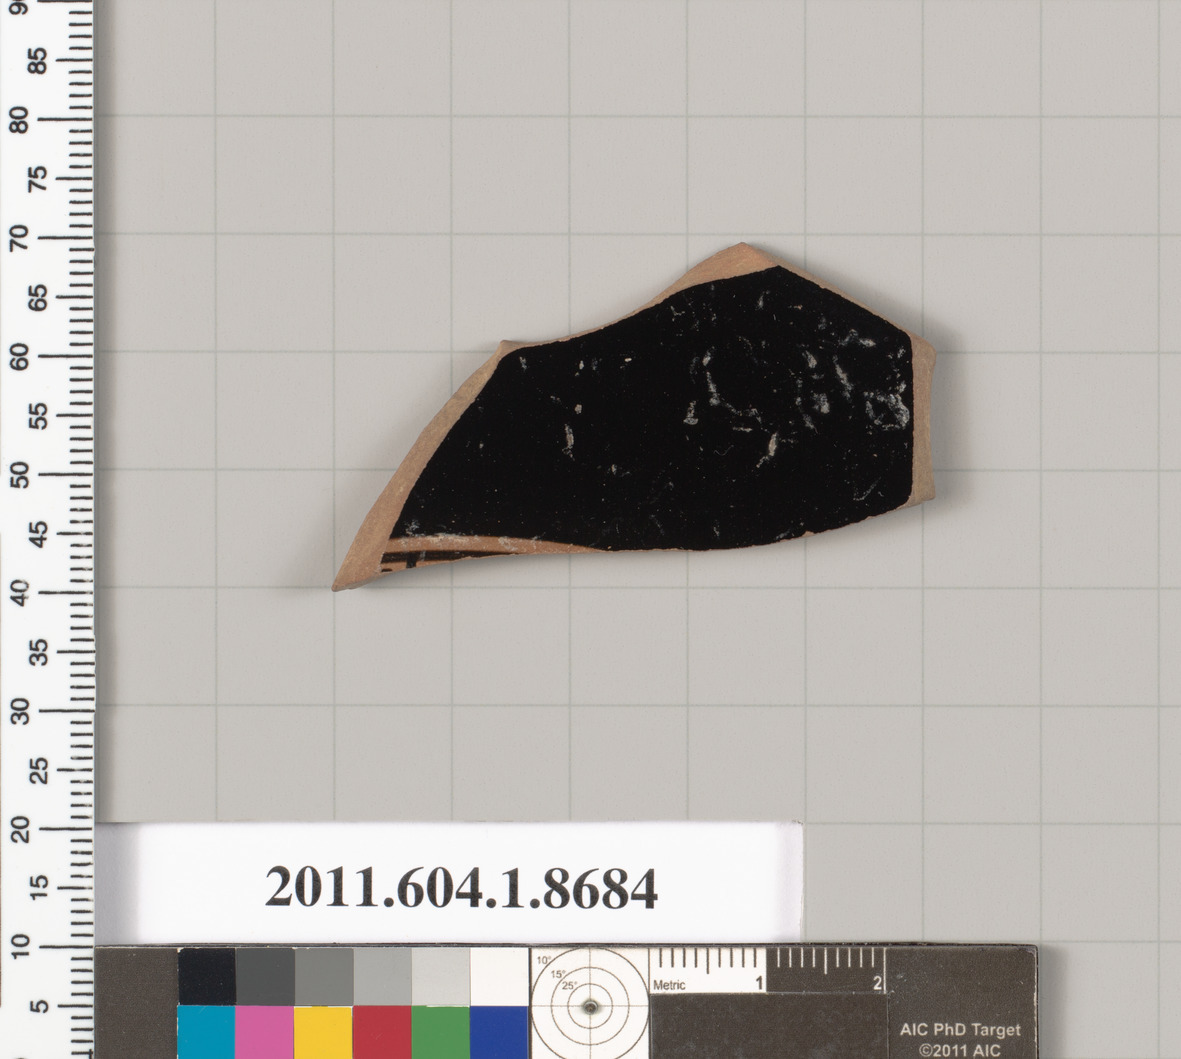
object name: kylix fragment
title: Terracotta fragment of a stemless kylix (drinking cup)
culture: greek, attic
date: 475-451 BCE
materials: terracotta